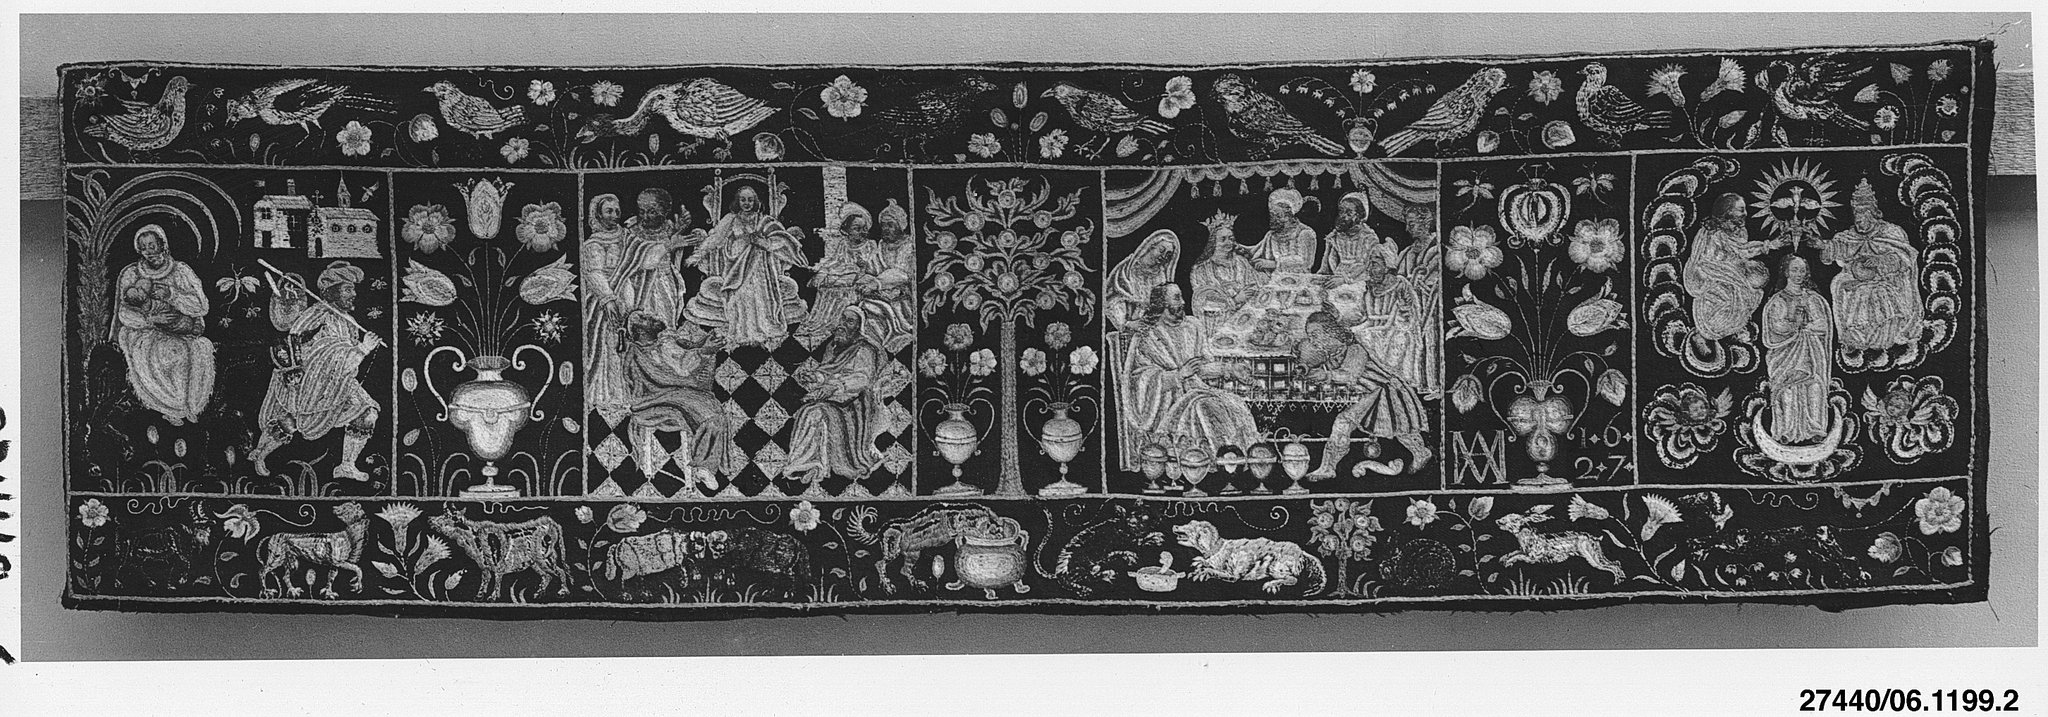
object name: border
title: Border with scenes from the Life of Christ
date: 1627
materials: silk, wool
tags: birds,dogs,christ,virgin mary